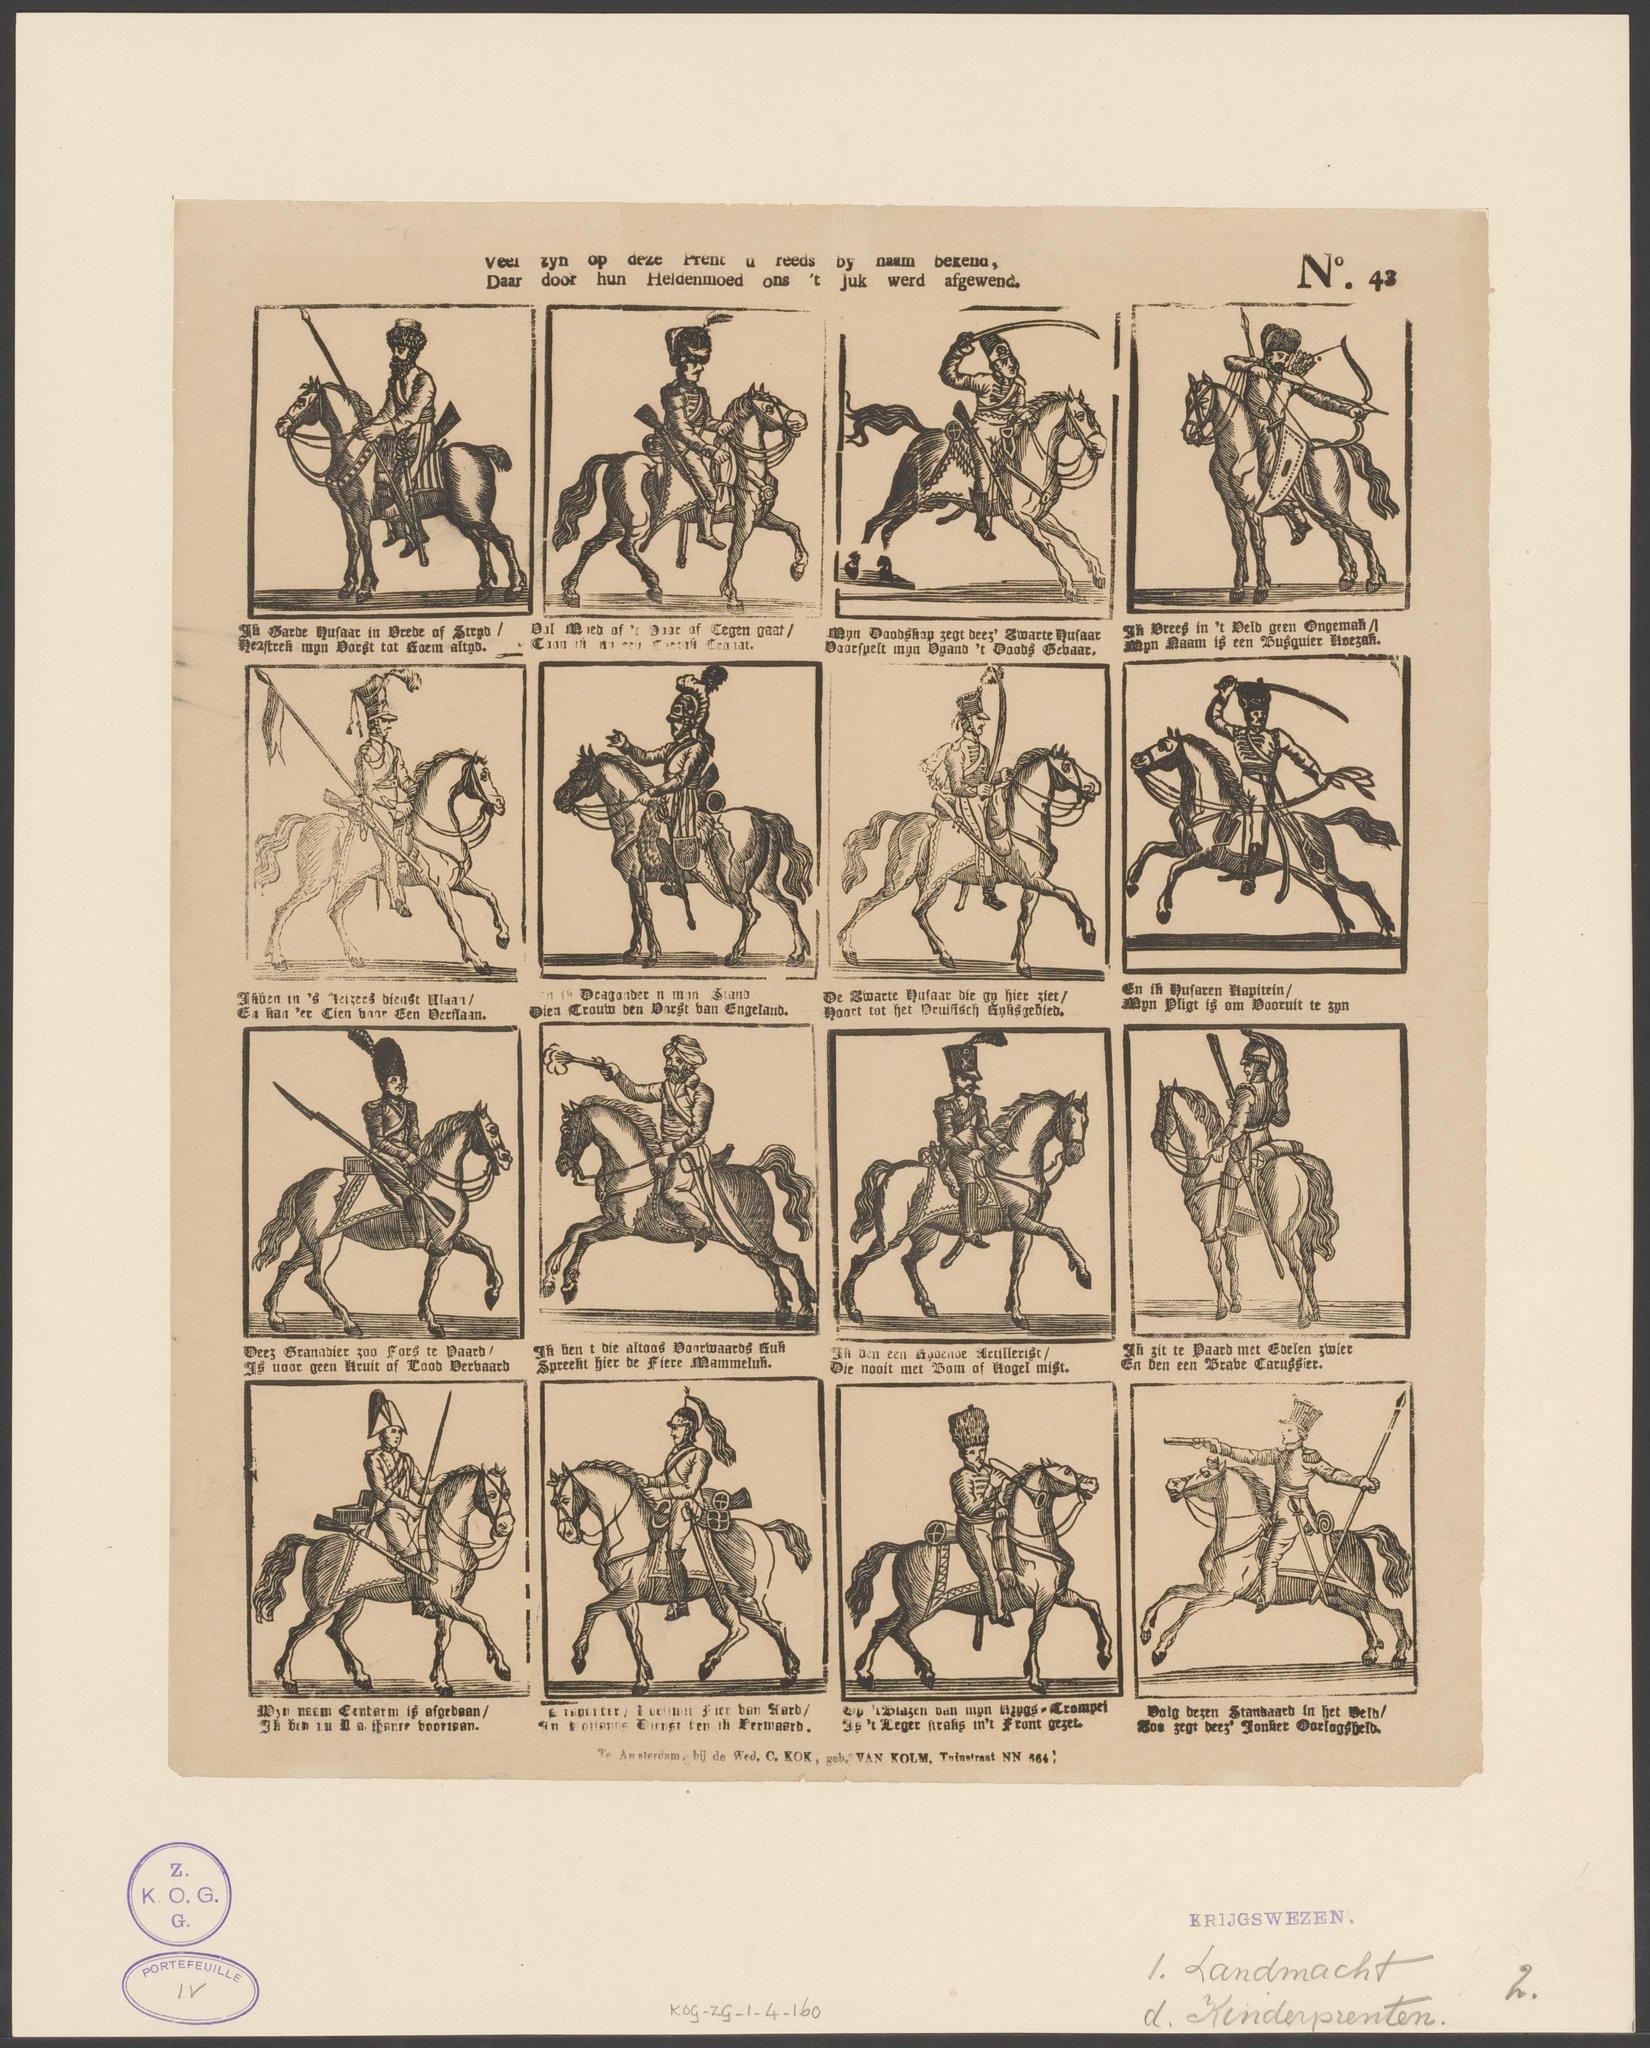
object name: popular print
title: Veel zyn op deze prent u reeds by naam bekend, / Daar door hun heldenmoed ons 't juk werd afgewend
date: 1842-1866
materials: paper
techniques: woodcut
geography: netherlands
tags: warfare; military affairs (+ cavalry, horsemen)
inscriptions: collector's mark: Lugt 1641, collector's mark